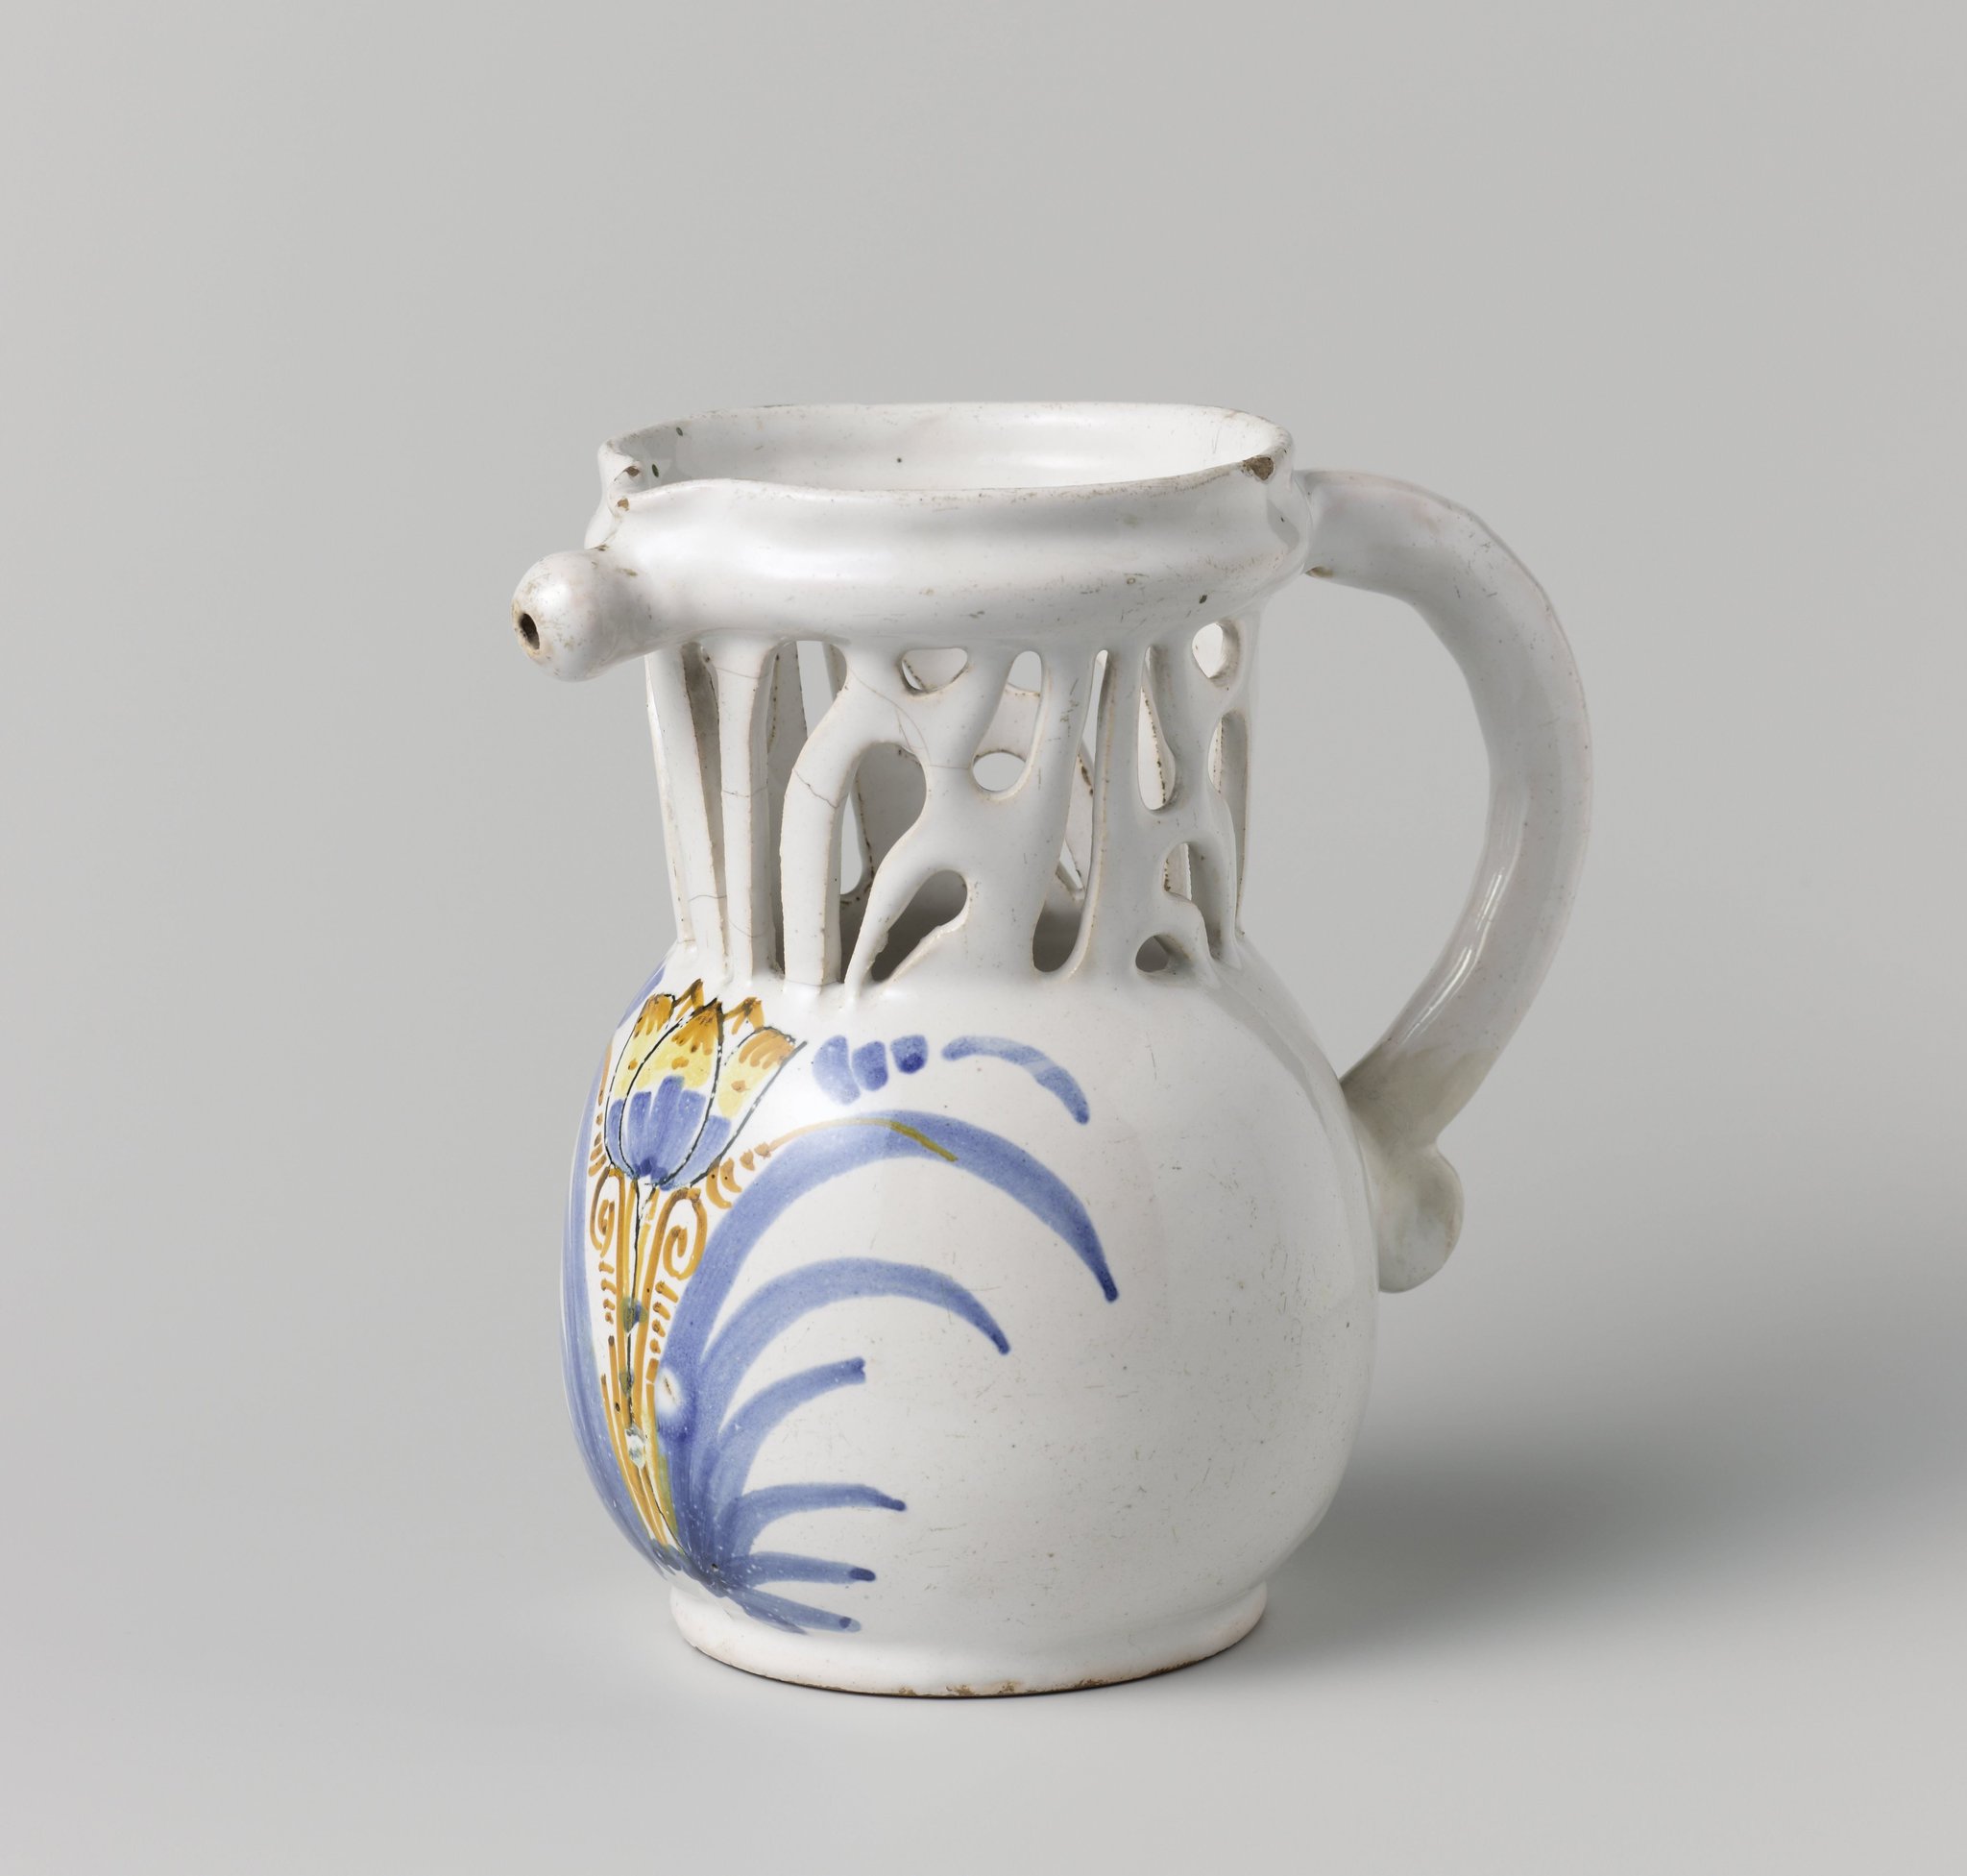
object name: puzzle jug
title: Fopkan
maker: Anonymous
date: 1650-1670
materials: earthenware, glaze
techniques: painted, polychromy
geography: delft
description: Fopkan op een standring, van veelkleurig beschilderde faience. De hals is opengewerkt, het oor is c-vormig en op de buik is een bloem met bladeren in de kleuren blauw, geel en geel-bruin geschilderd.